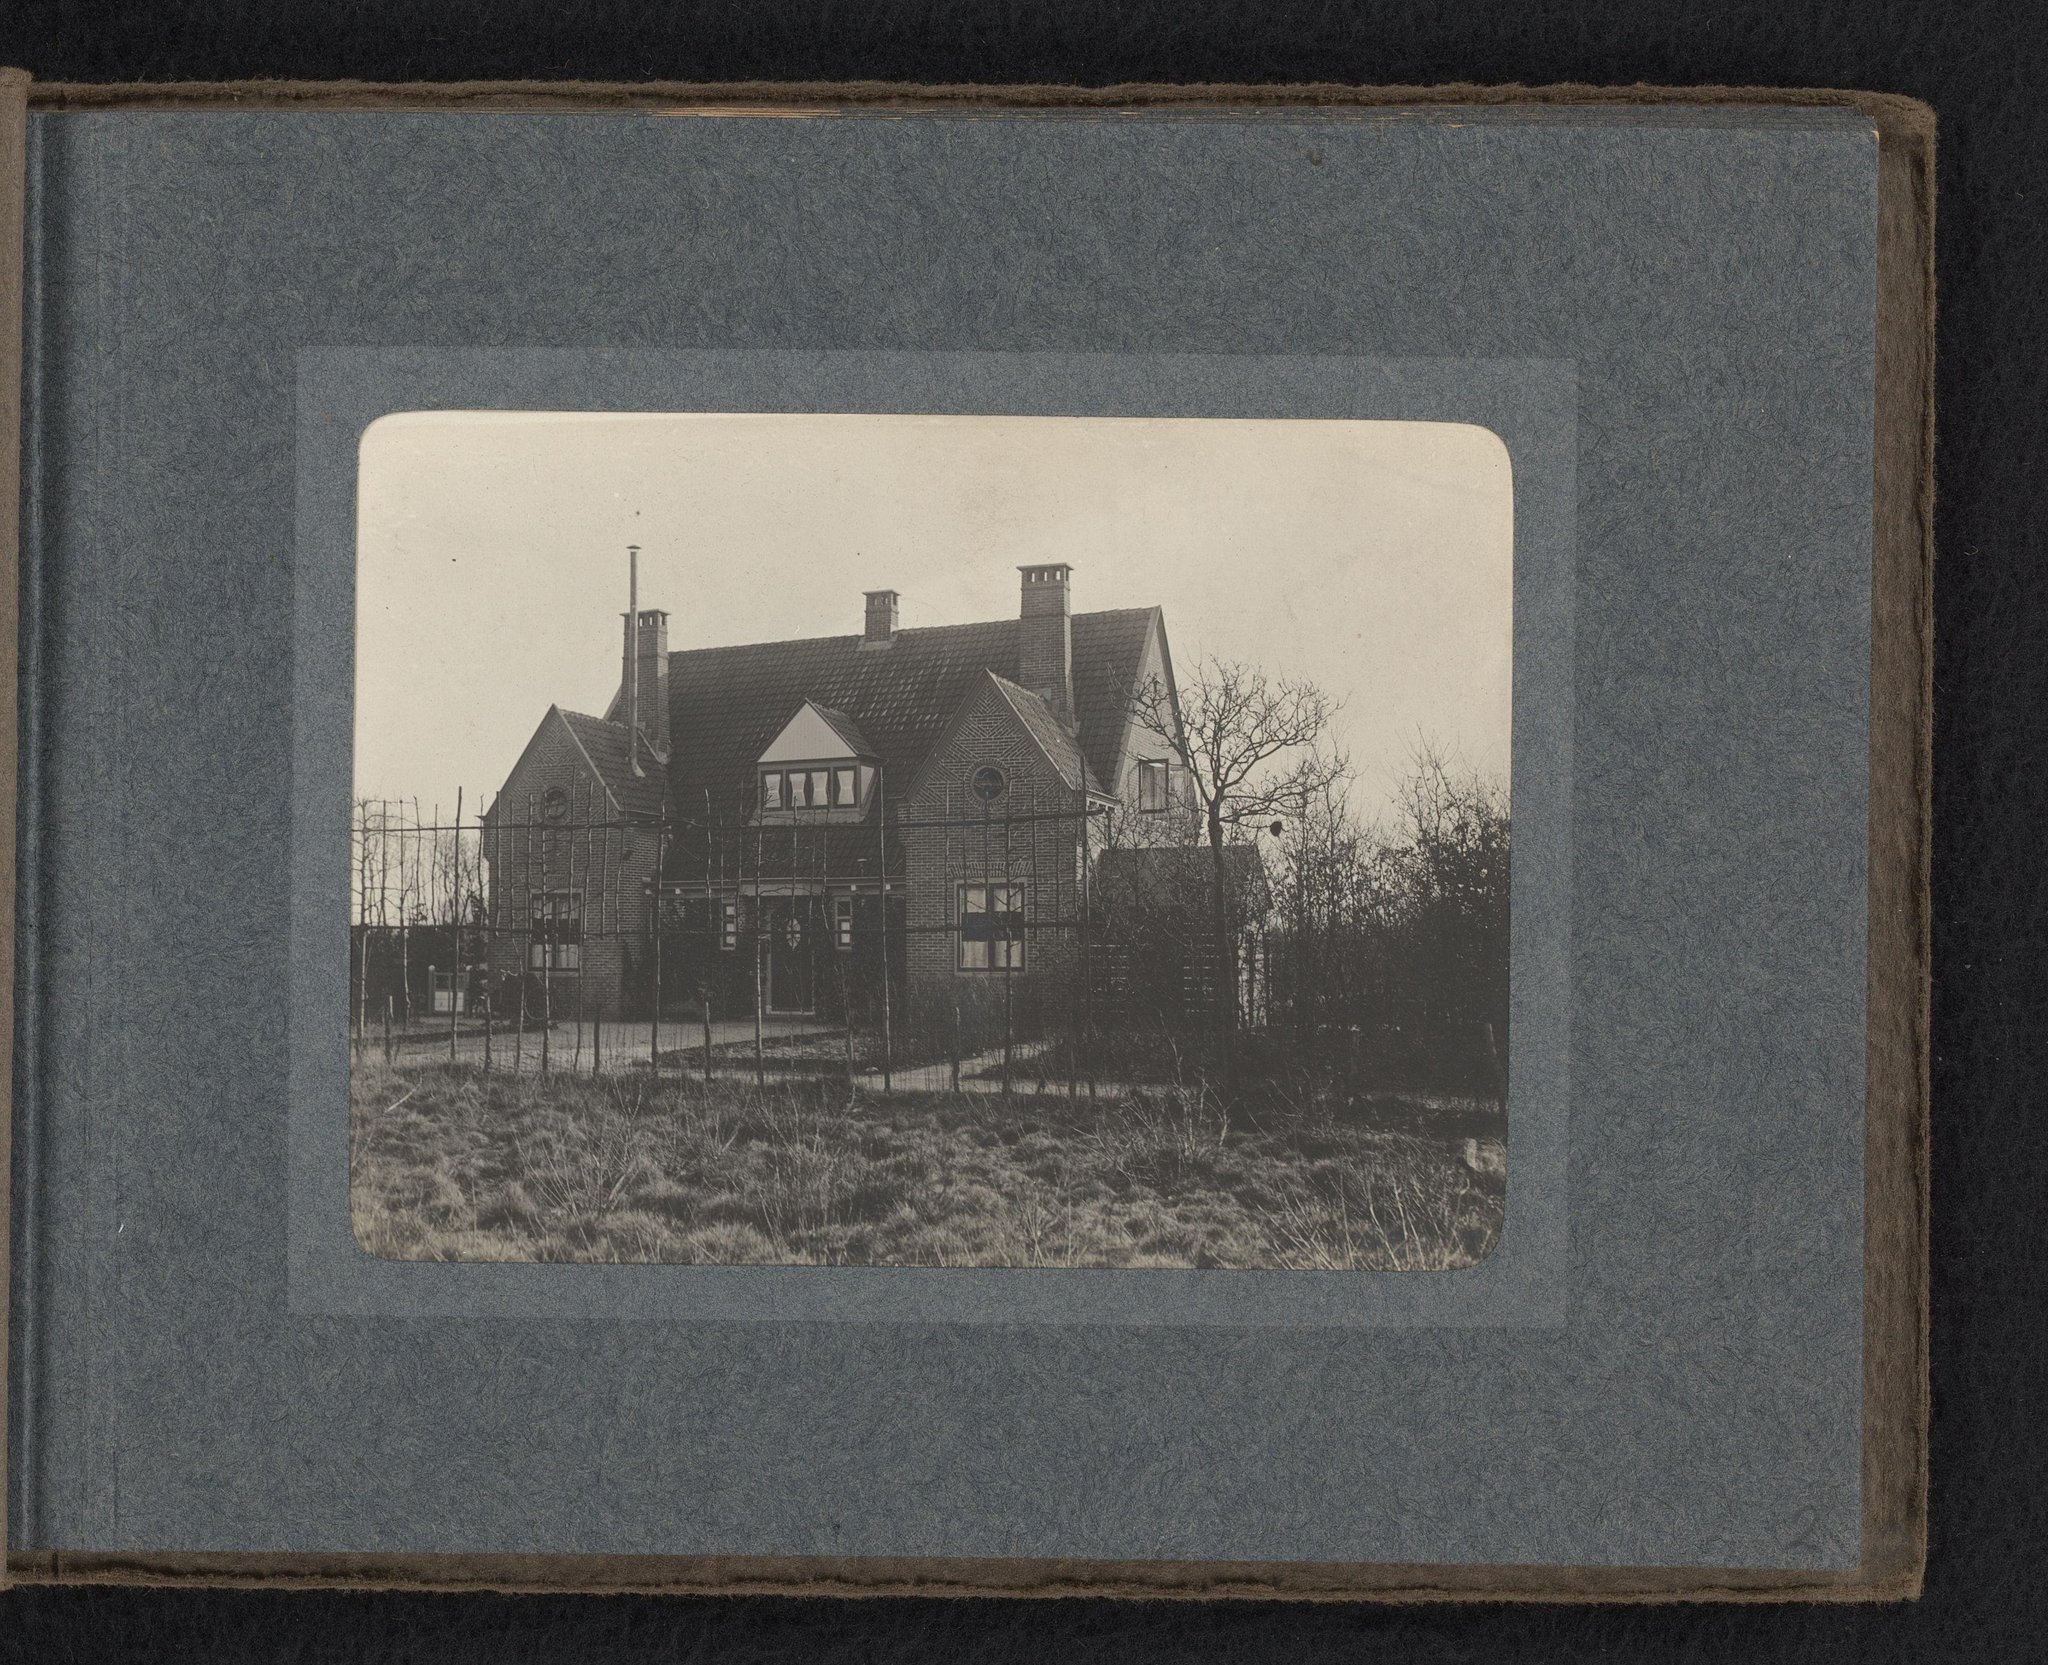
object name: photograph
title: Gezicht op een huis in Blaricum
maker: hendrik herman van den berg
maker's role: amateurfotograaf, jurist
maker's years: 1875-1944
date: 1913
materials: paper, cardboard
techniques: gelatin silver print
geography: blaricum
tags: village, villa